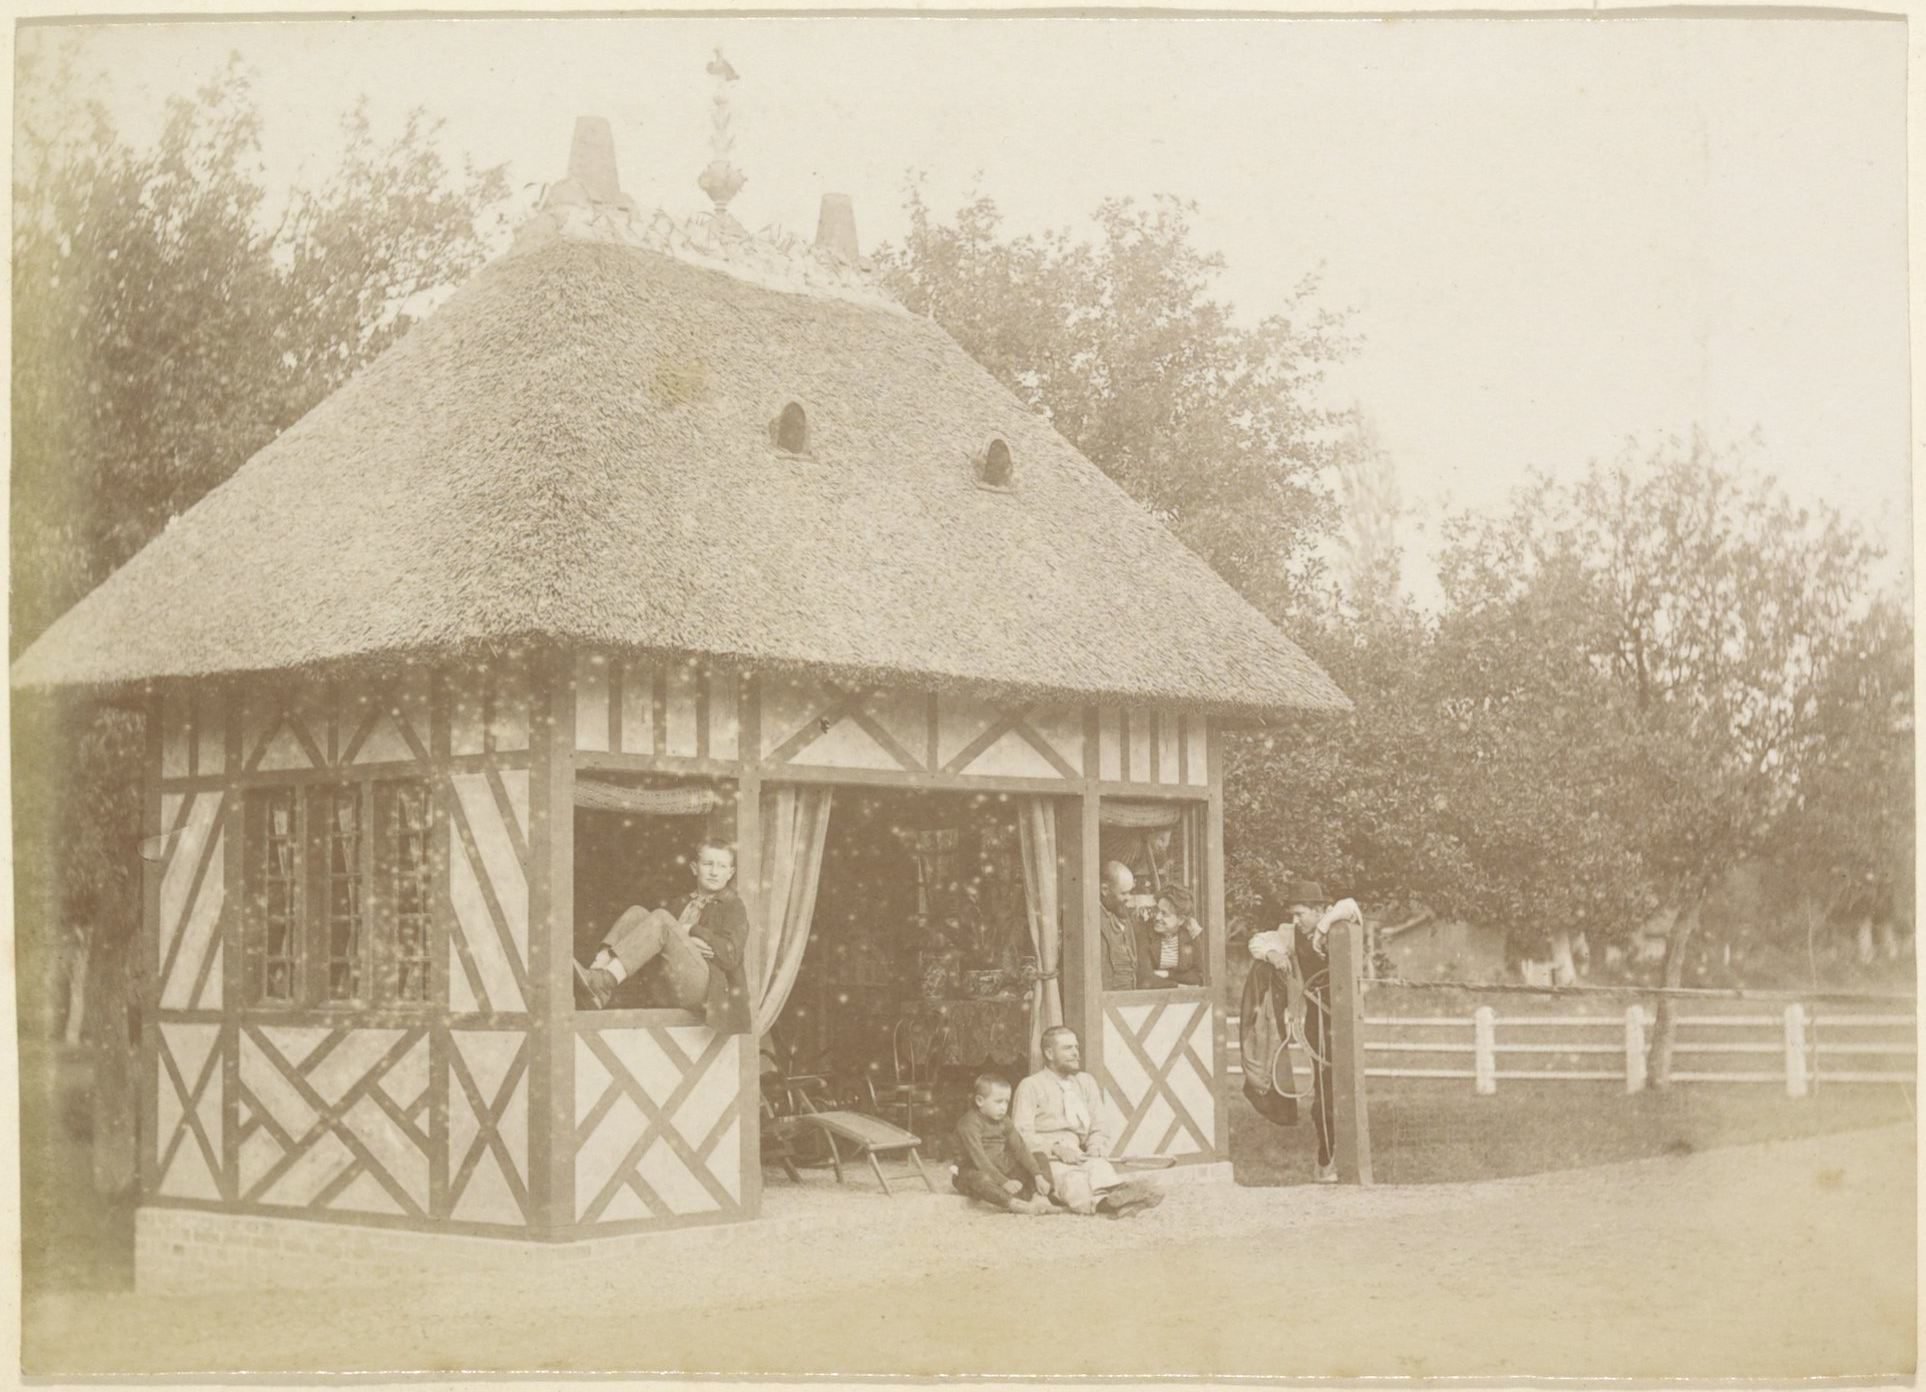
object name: photograph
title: Gezelschap bij een tuinhuis met rieten dak in Frankrijk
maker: Anonymous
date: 1900-1910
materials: paper, photographic support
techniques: albumen print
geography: france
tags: roof-covering, summer-house, arbour, garden-house (dutch: 'theekoepel'), france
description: Onderdeel van Fotoalbum van een Franse amateurfotograaf met opnames van een familie, distilleerderij Delizy & Doistau Fils, het leger en bezienswaardigheden in Frankrijk.